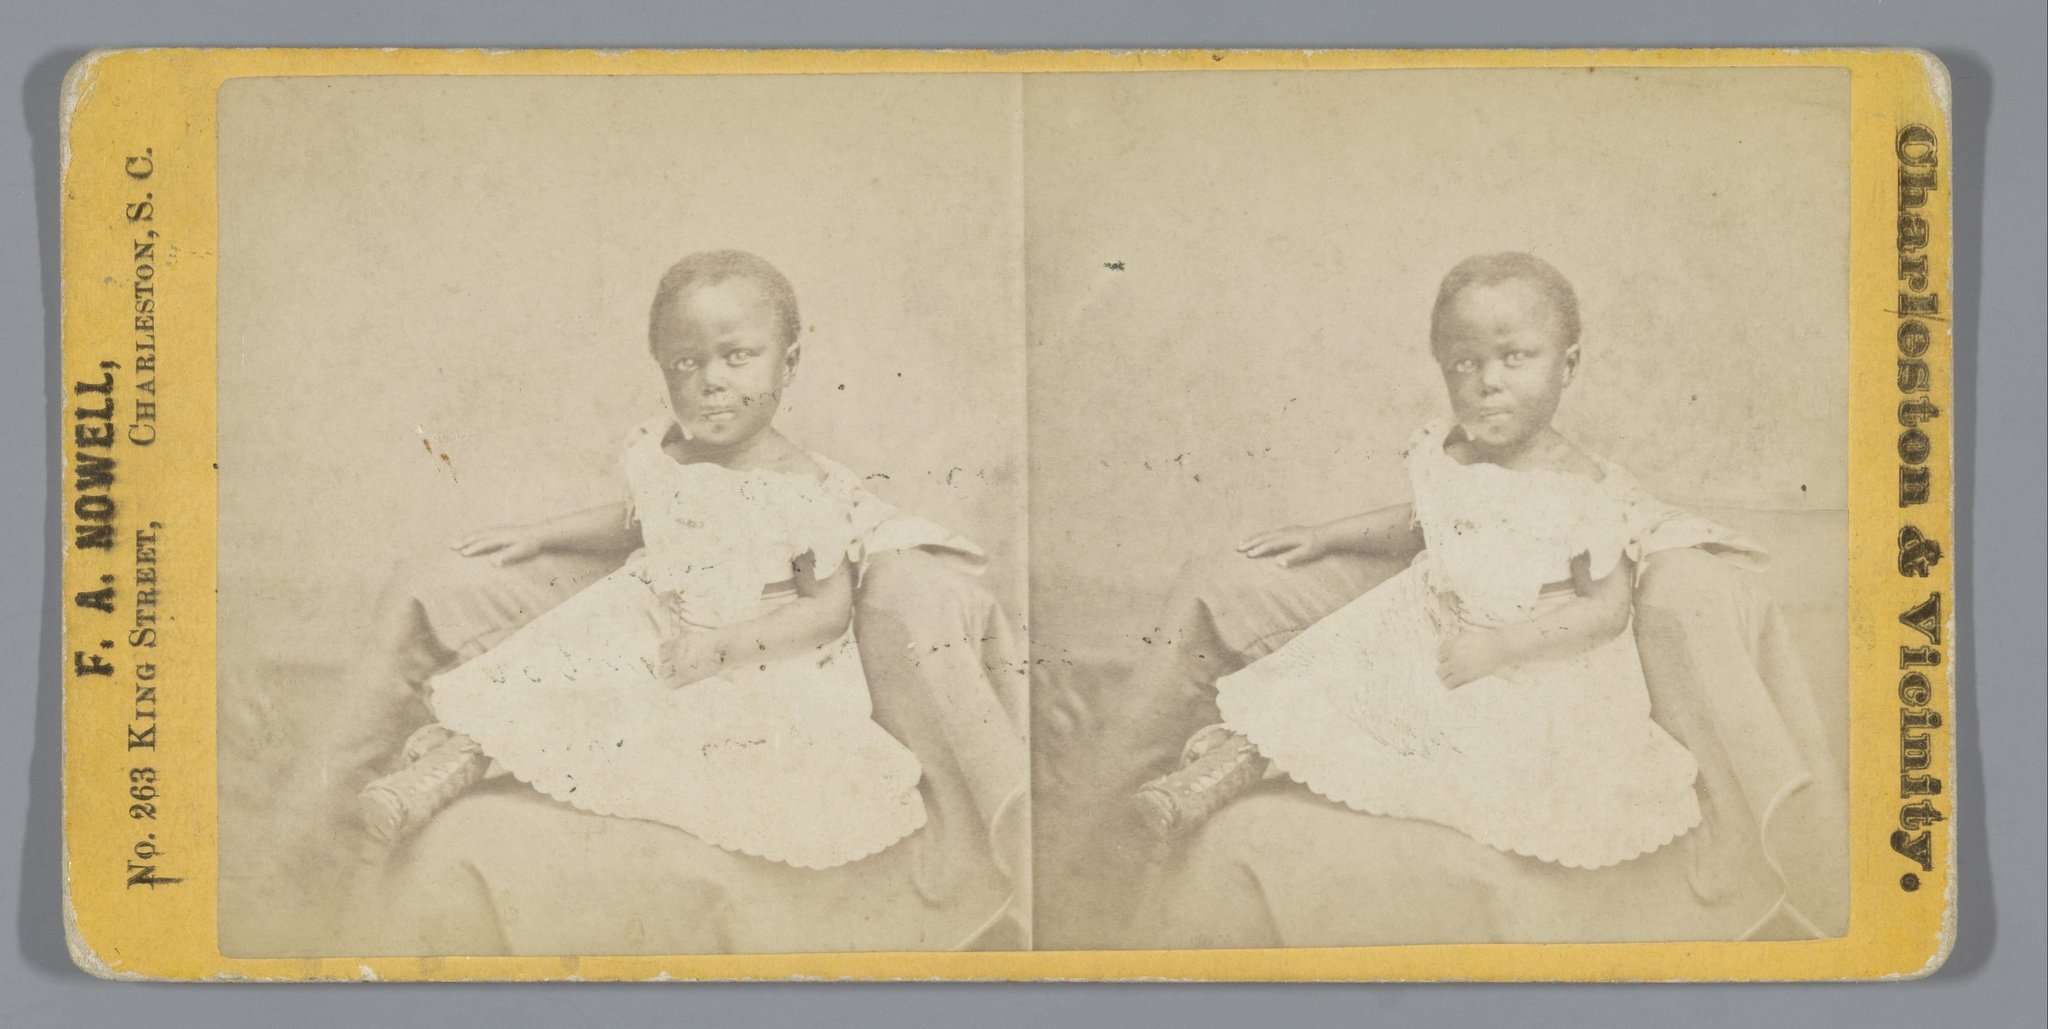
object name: stereograph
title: Portret van een zwart kind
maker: frank a. nowell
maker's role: publisher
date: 1868-1890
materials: cardboard, paper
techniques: albumen print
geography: charleston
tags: child, anonymous historical person portrayed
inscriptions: inscription: ‘CATALOGUE OF VIEWS OF CHARLESTON AND VICINITY./ NO. DESCRIPTION./ 1 East Battery./ 2 " "/ 3 South "/ (...)’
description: Portret van een Afro-Amerikaans meisje in een witte jurk.